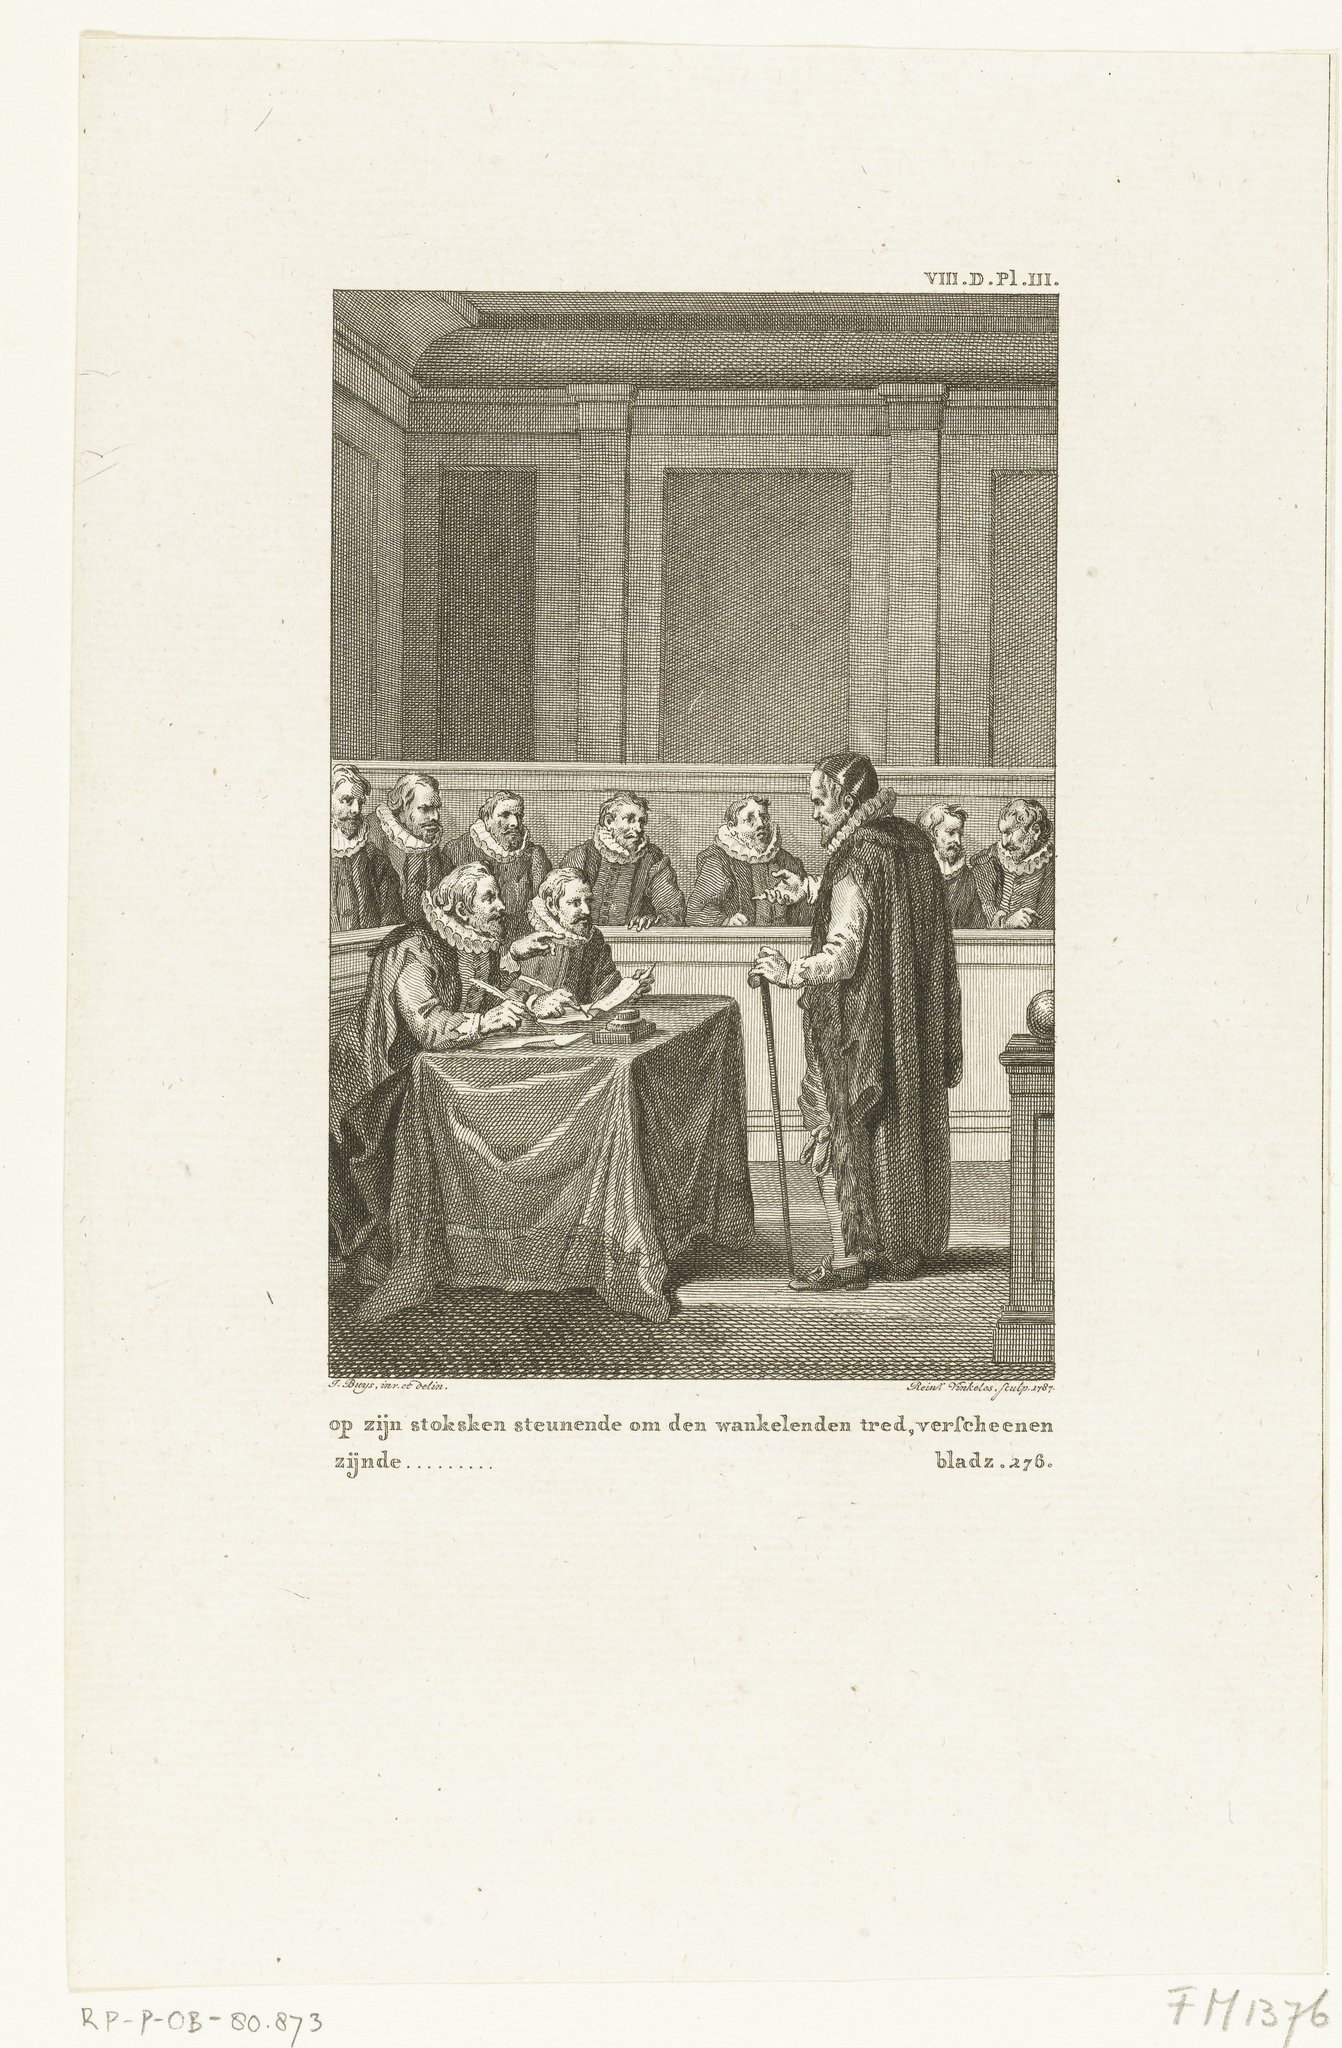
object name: history print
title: Johan van Oldenbarnevelt verschijnt voor zijn rechters, 1619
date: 1787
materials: paper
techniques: etching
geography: netherlands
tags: the hague, johan van oldenbarnevelt, magistracy, judges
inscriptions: collector's mark: Lugt 195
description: Gebruikt als illustratie, waarschijnlijk in: Vaderlandsche historie verkort, van den jaare 1751 tot op 1788. Ten vervolge op dat van Jan Wagenaar, Amsterdam 1791, dl. VIII, pl. III.